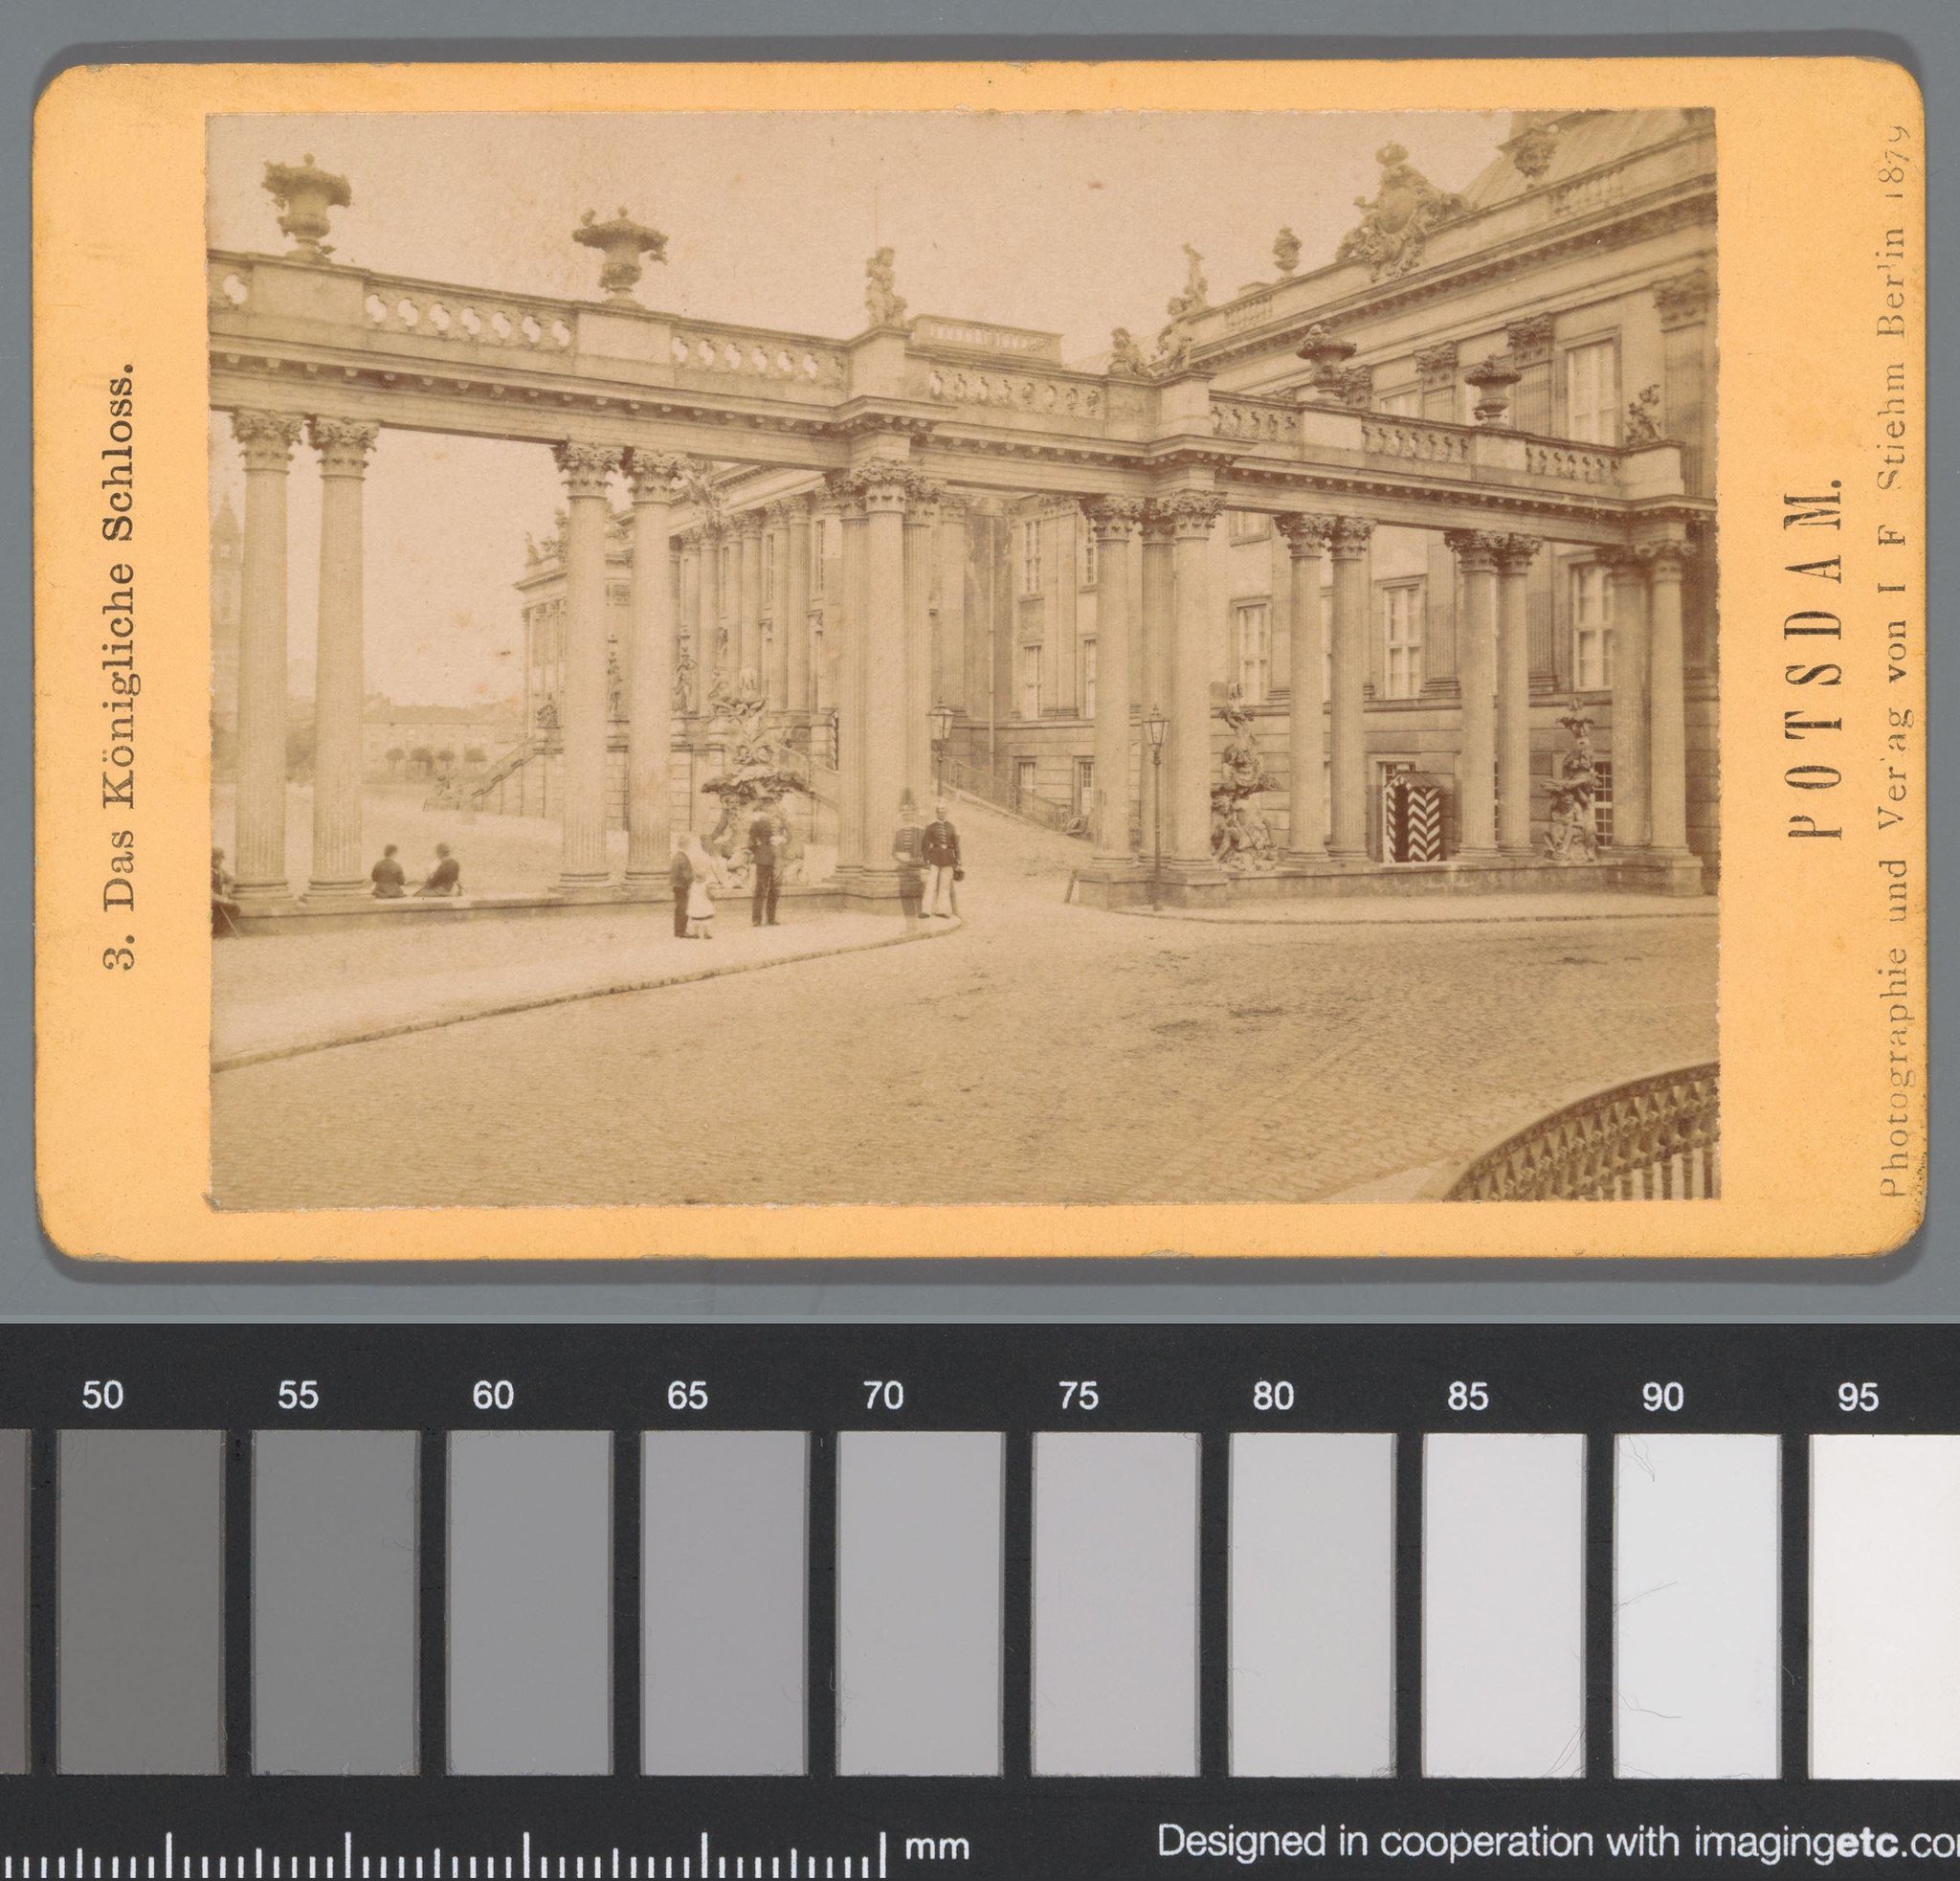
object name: carte de visite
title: Potsdam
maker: johann friedrich stiehm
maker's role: fotograaf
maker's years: 1826-1902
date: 1879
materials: cardboard, paper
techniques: albumen print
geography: berlin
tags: colonnade, palace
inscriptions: number: ‘3.’